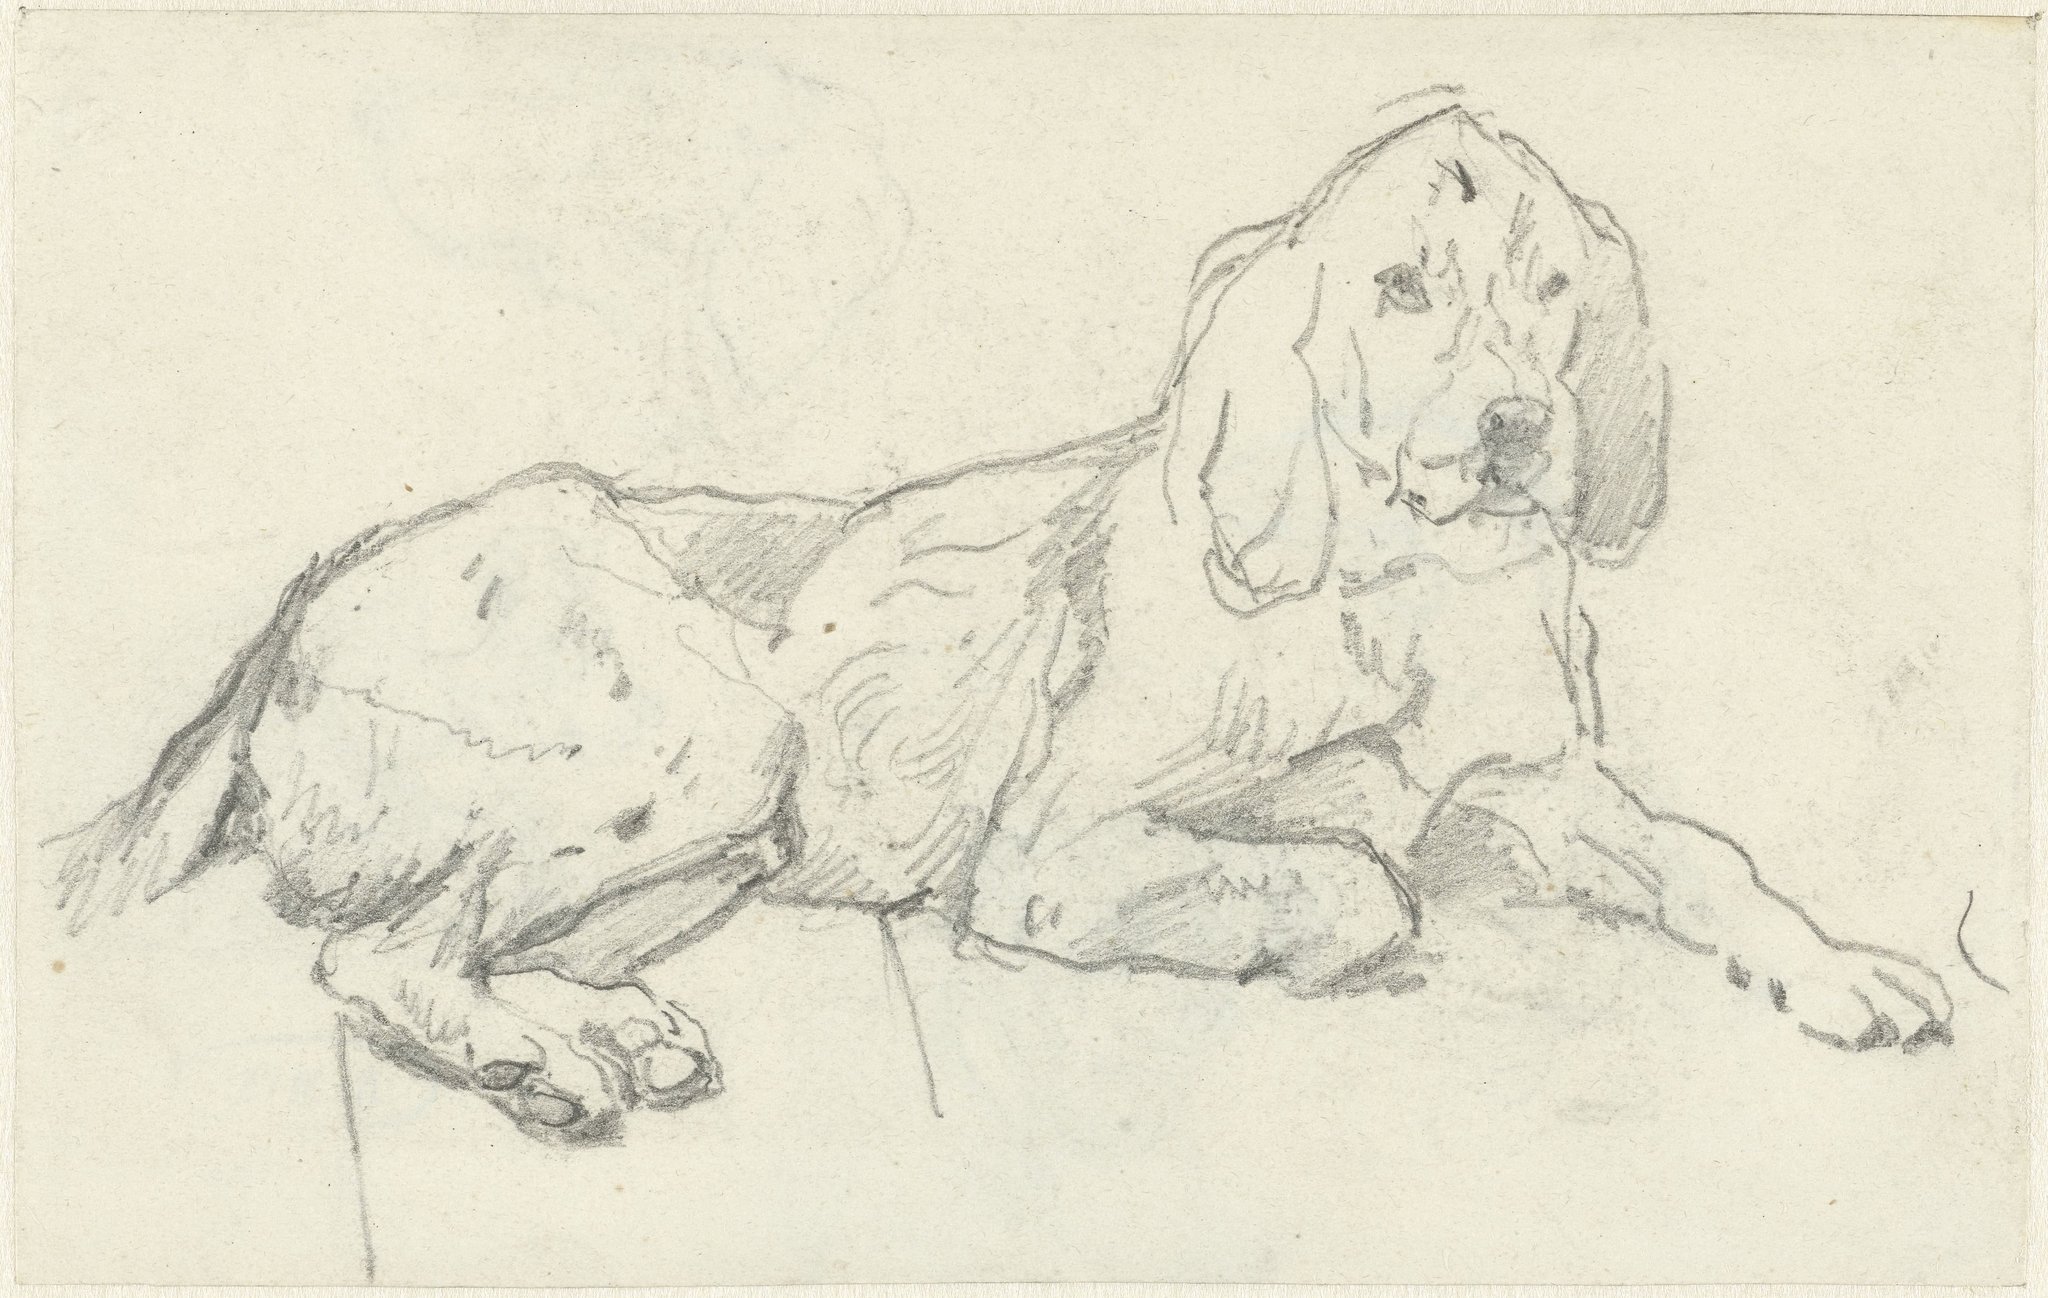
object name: drawing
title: Studies van een jachthond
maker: guillaume anne van der brugghen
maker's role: draughtsman, print maker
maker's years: 1812-1891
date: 1886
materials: paper, pencil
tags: hunting dogs, dog